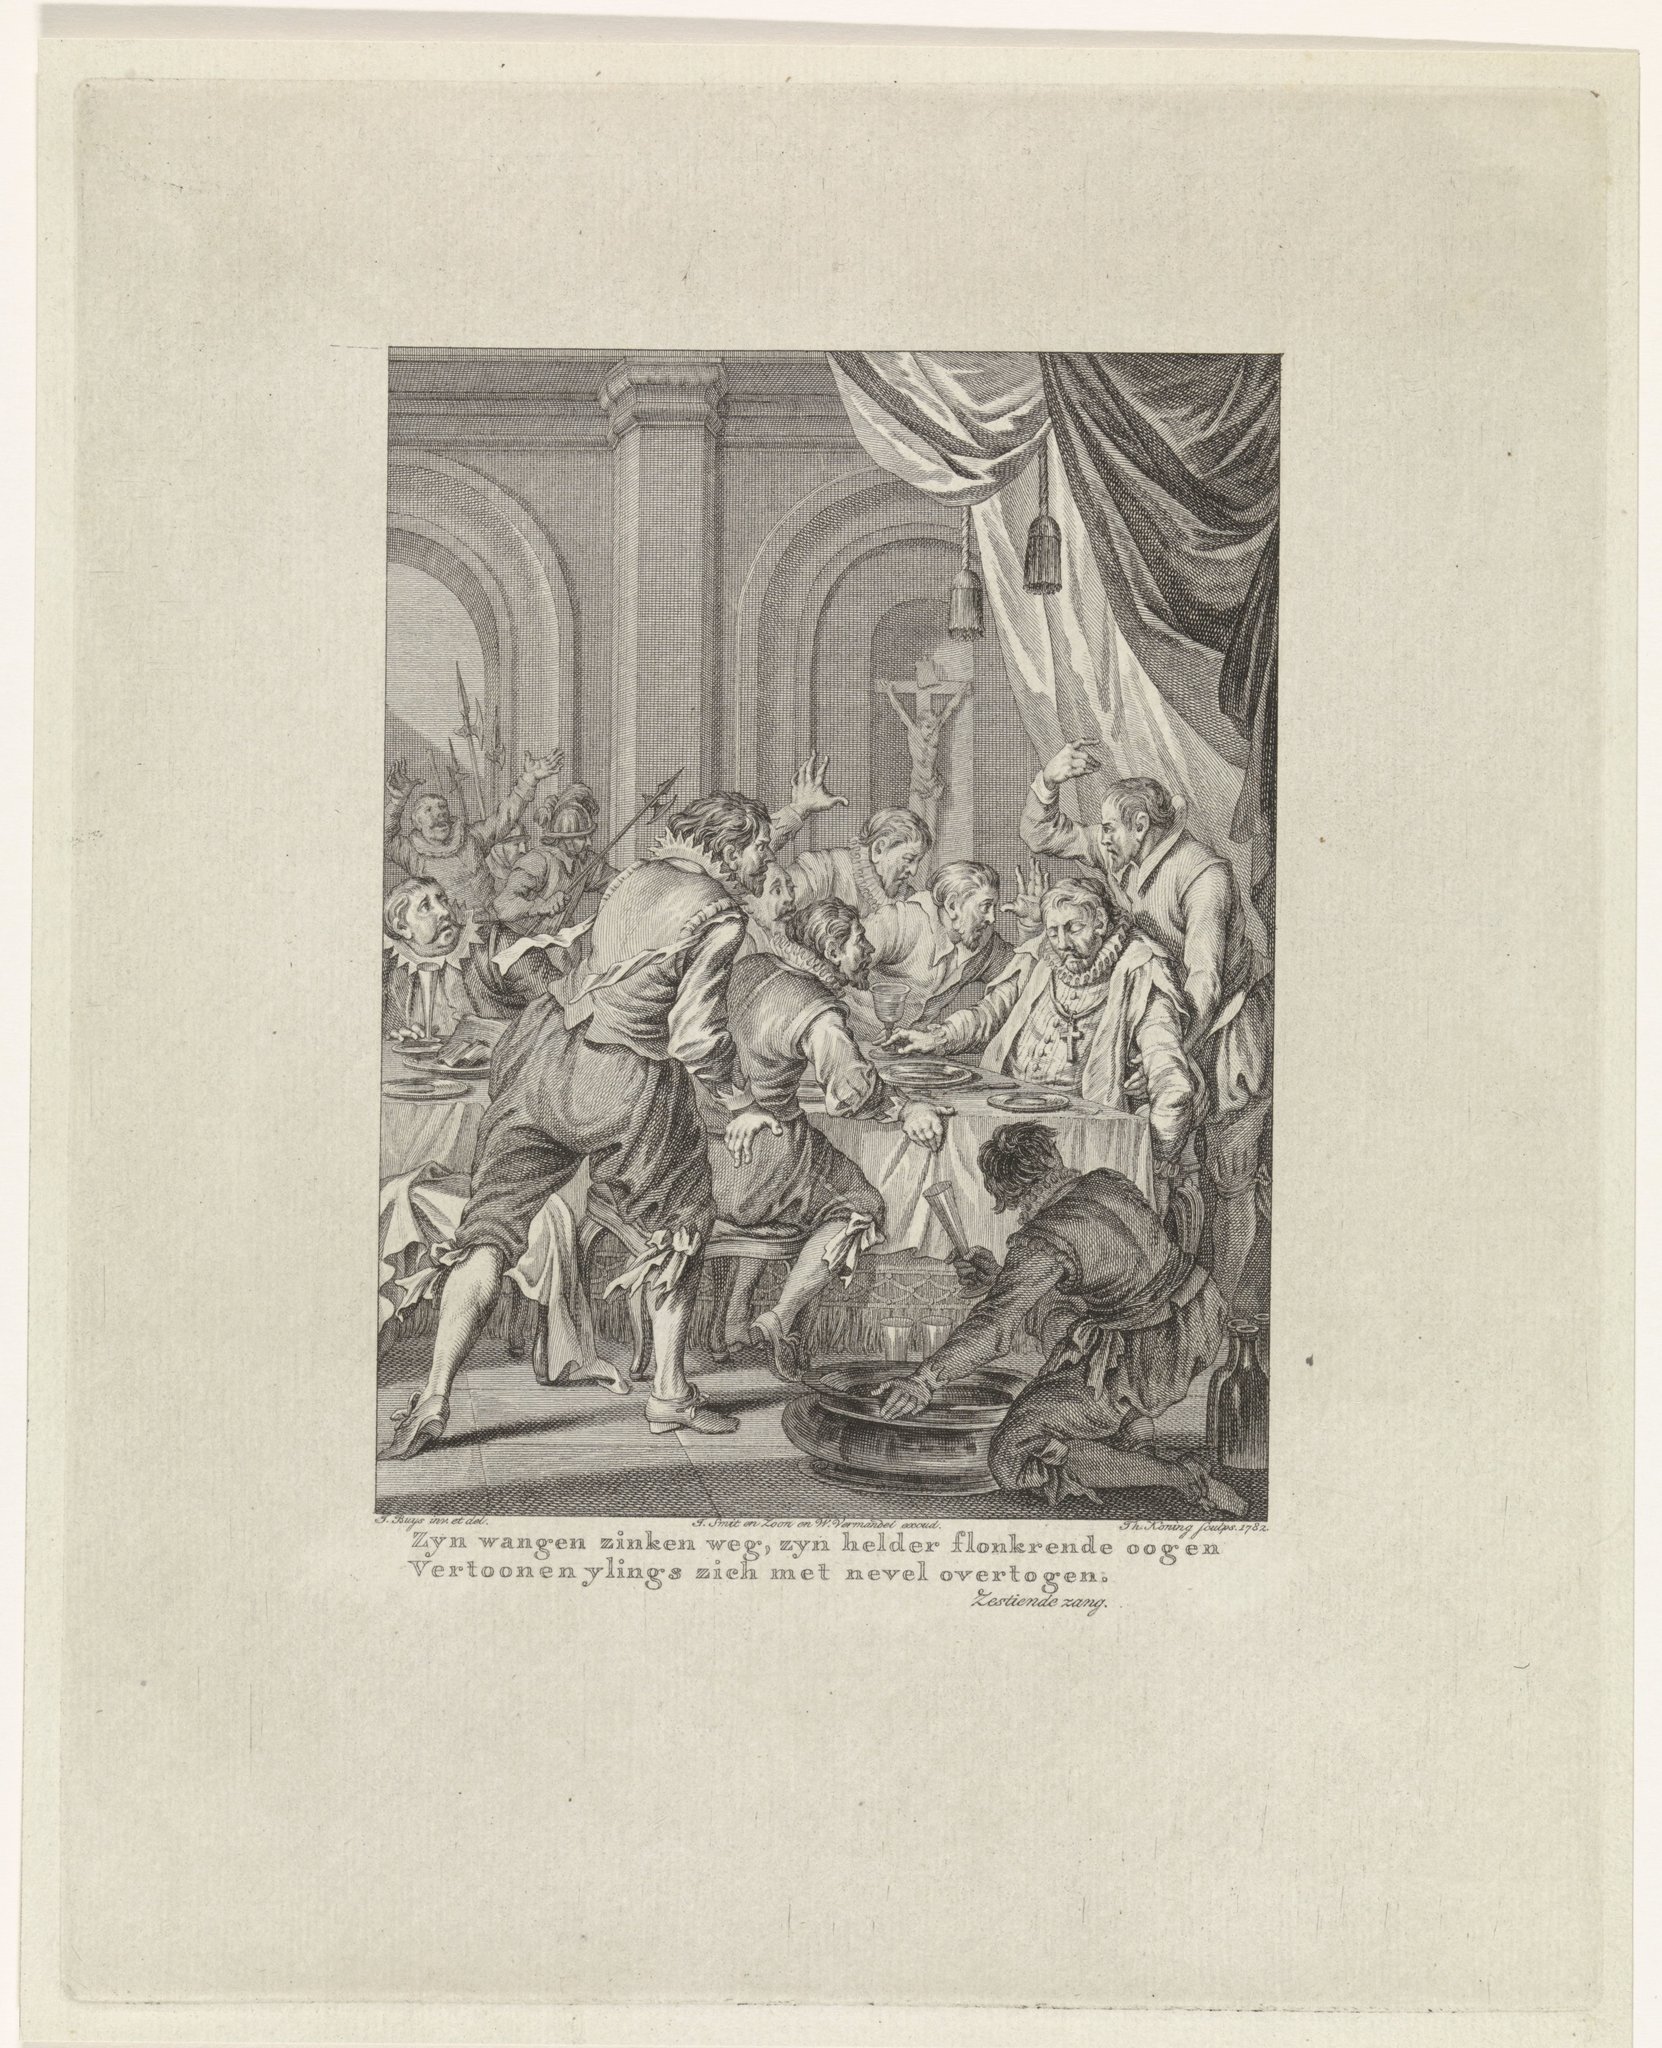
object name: print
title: Dood van Requesens, 1576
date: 1782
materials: paper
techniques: engraving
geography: amsterdam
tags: brussels, mayor, luis de zúñiga y requesens, altarcross, crucifix, dying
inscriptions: collector's mark: Lugt 2228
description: De Spaanse legeraanvoerder en landvoogd van de Nederlanden Requesens sterft onverwacht aan tafel tijdens een banket in Brussel, 5 maart 1576. Om hem heen verschrikte mannen die wilde gebaren maken. Deze prent maakt deel uit van een serie van 24 prenten met taferelen uit het leven van prins Willem I, 1568-1584 en is een illustratie bij de zestiende zang.